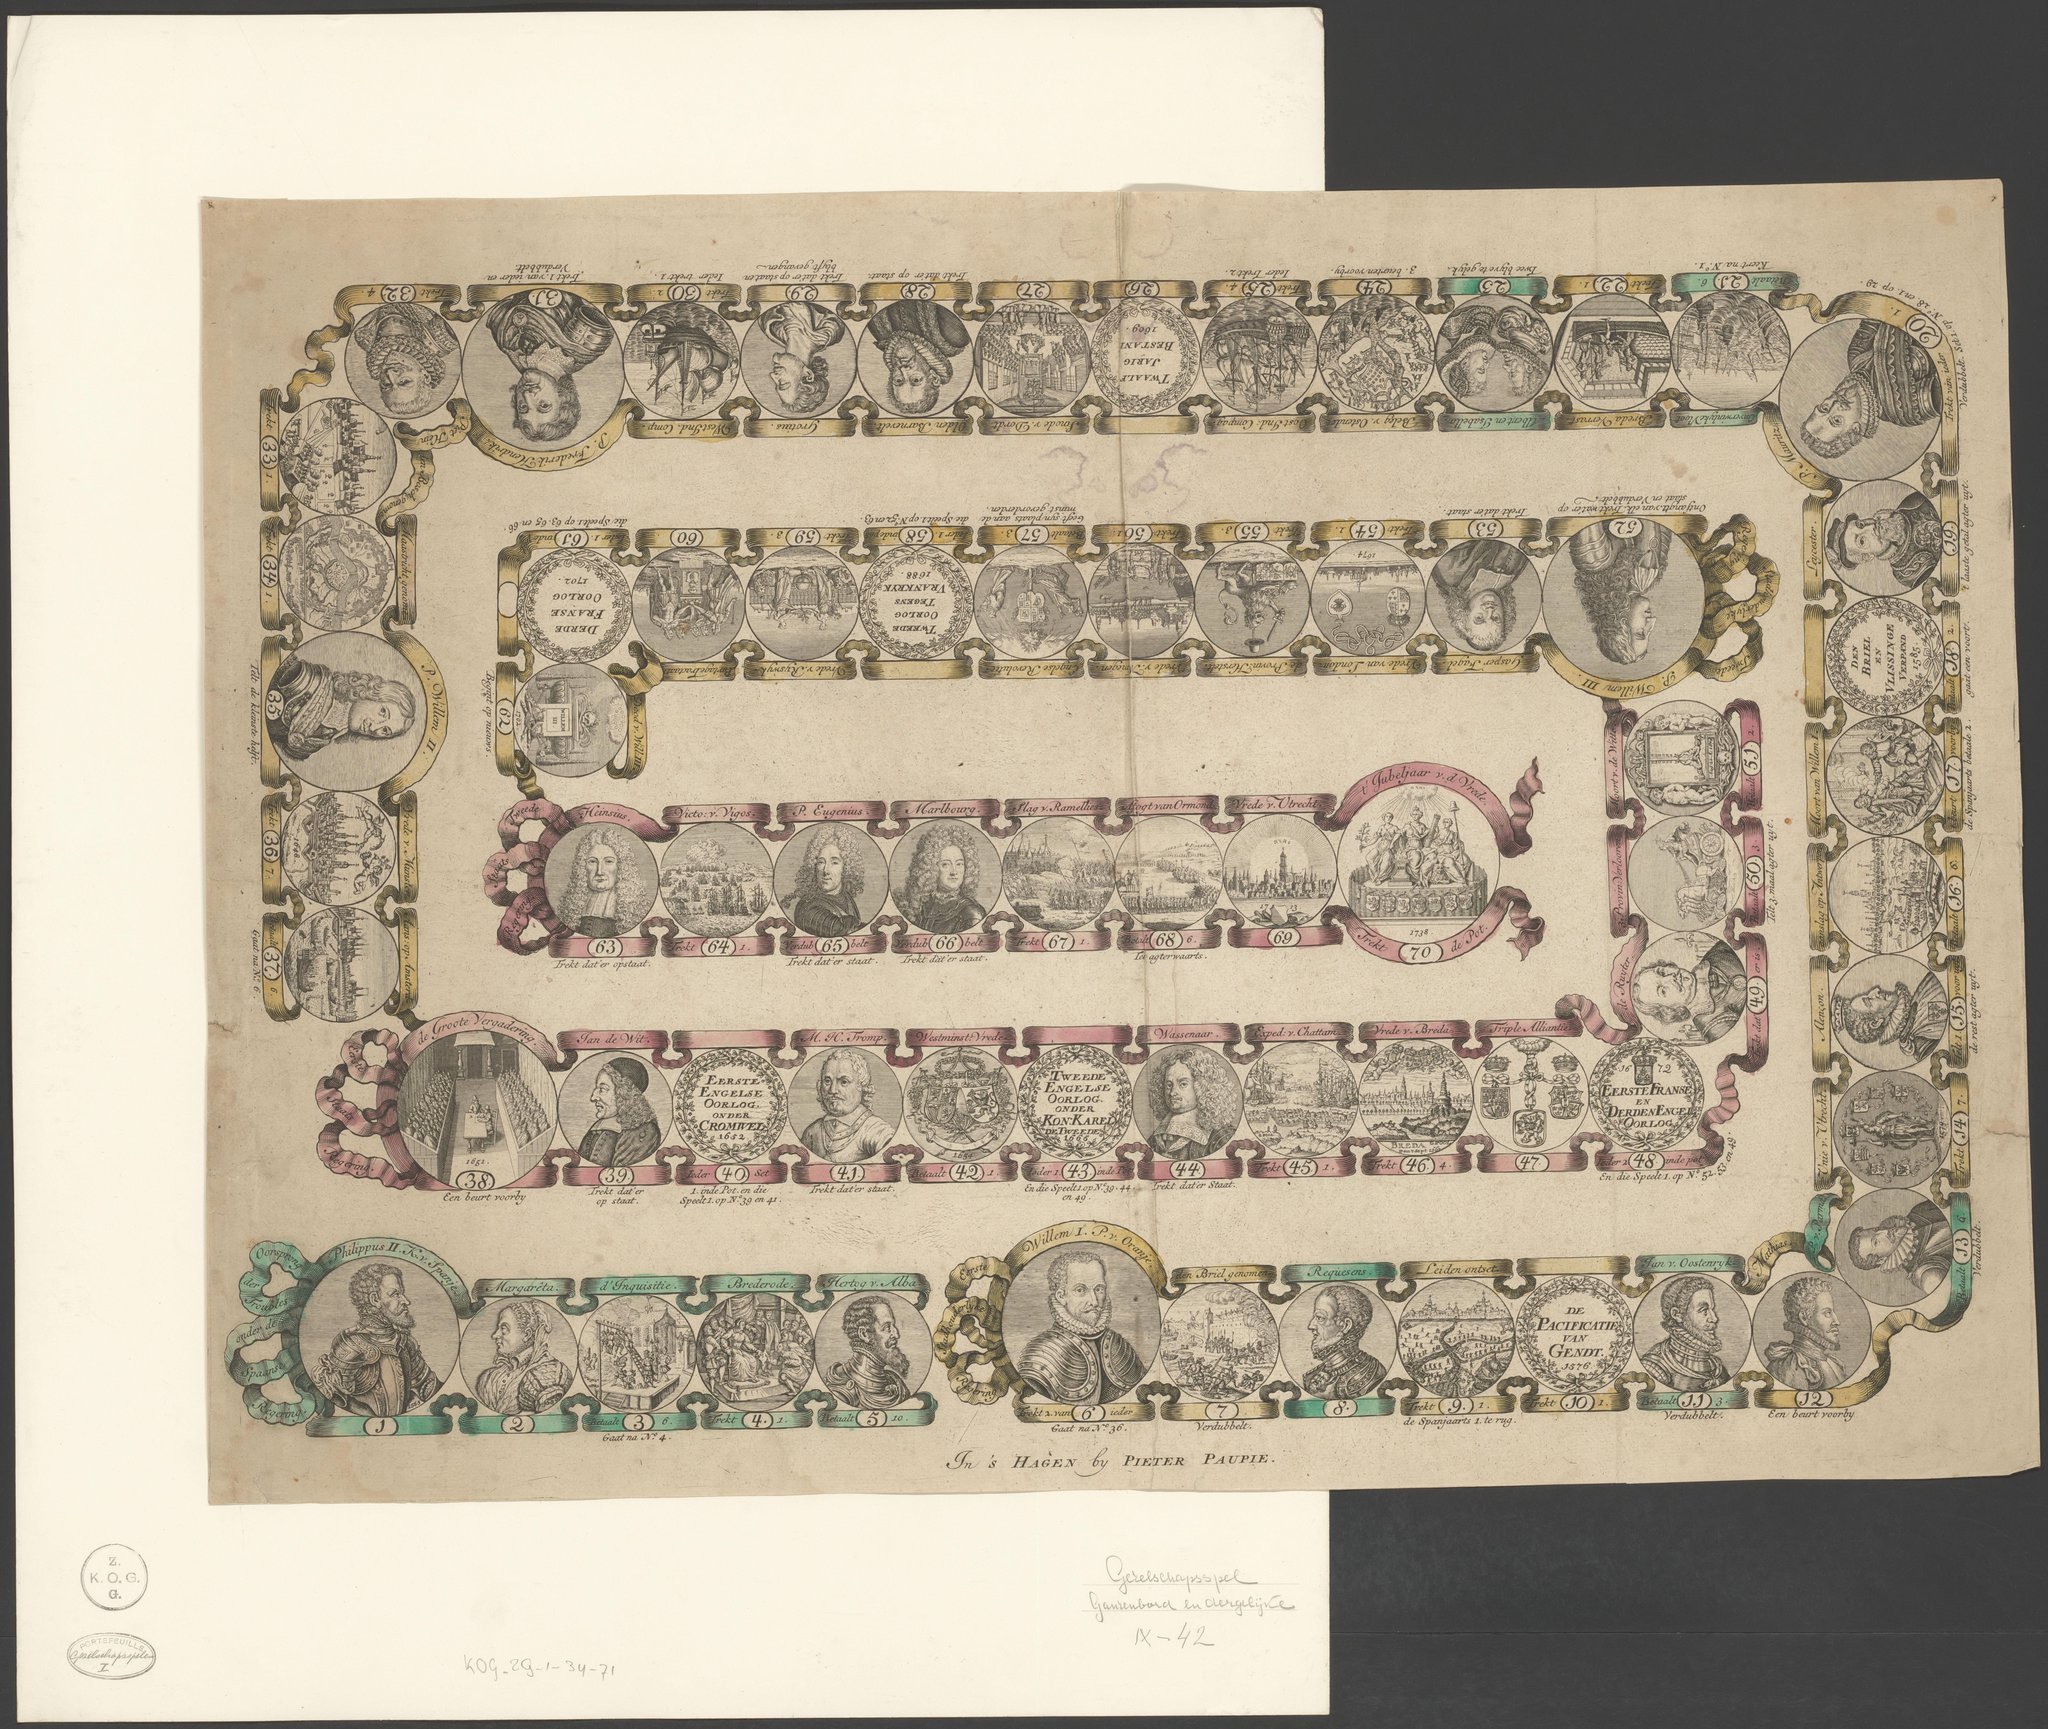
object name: gameboard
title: Spel verbeeldende de historie van Holland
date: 1742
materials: paper, watercolor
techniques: etching, hand coloring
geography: netherlands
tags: board-games of chance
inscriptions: collector's mark: Lugt 1641, collector's mark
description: Bordspel over de Nederlandse geschiedenis. Spel met 70 medaillons beginnend bij Filips II en eindigend bij het Jubeljaar 1738, het 25-jarig jubileum van de Vrede van Utrecht van 1713. Elk vakje verwijst naar een historische gebeurtenis of persoon. Onderwerpsrubrieken binnen de Atlas Zeden en Gewoonten: Spel en Vermaak; gezelschapsspel, ganzenbord en dergelijke.